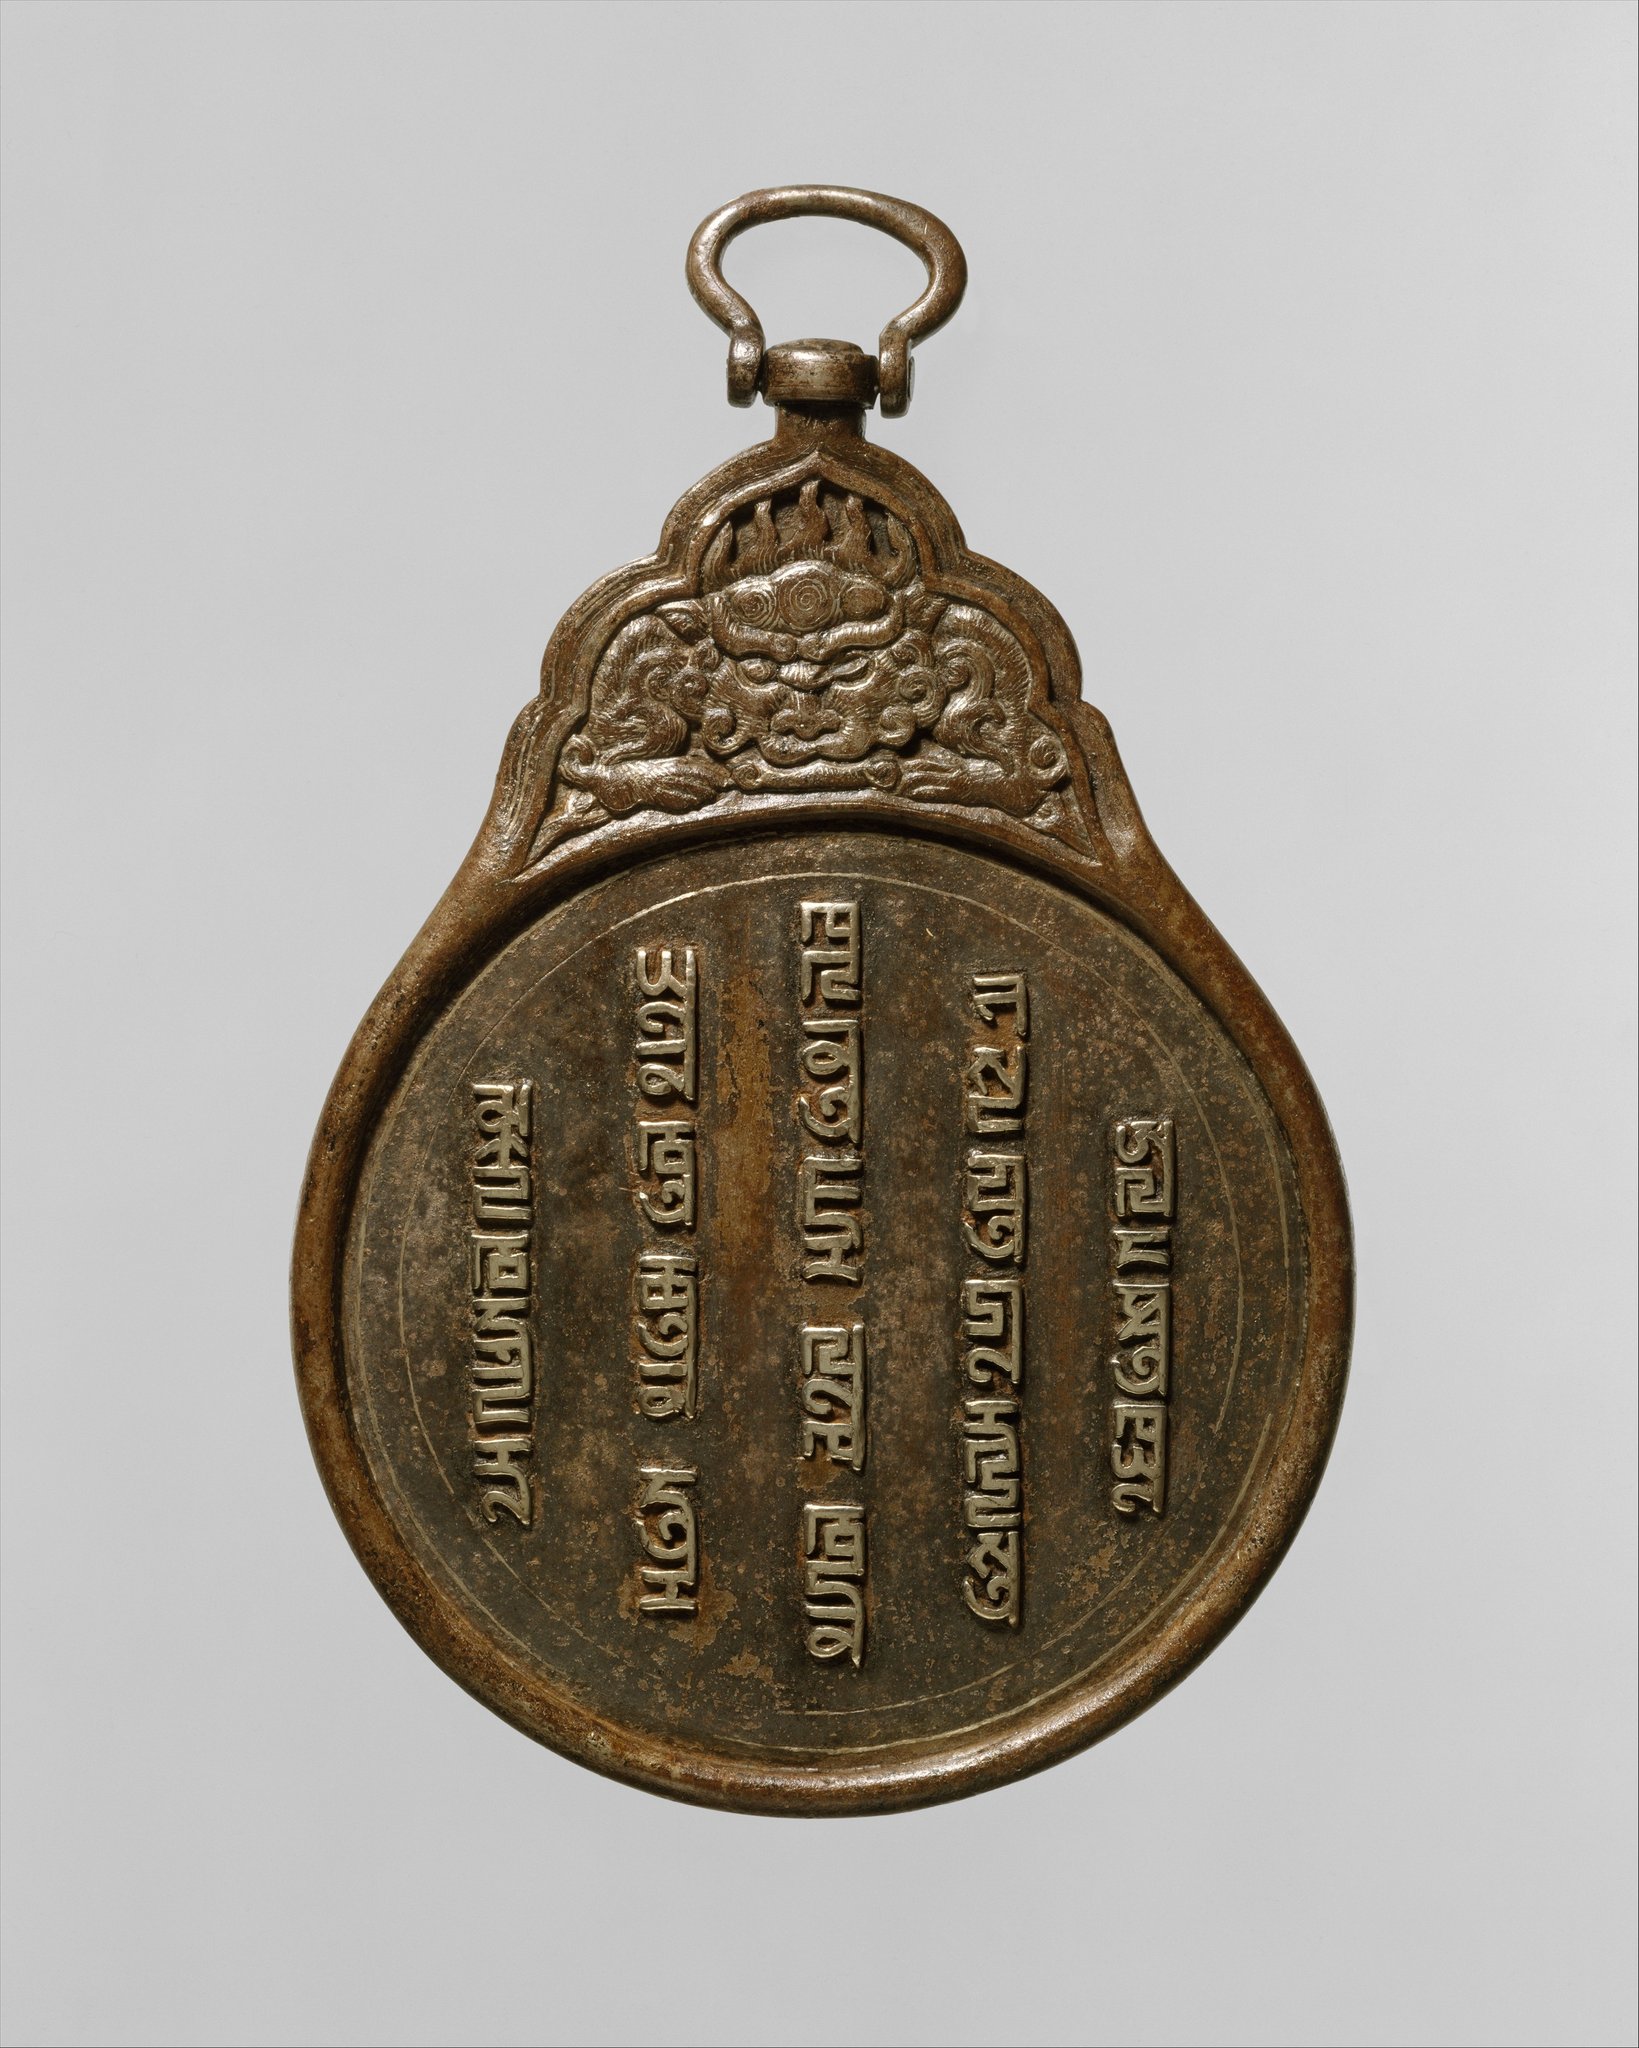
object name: pas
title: Safe Conduct Pass (Paiza) with Inscription in Phakpa Script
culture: chinese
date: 1267-1300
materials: iron, silver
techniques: inlay